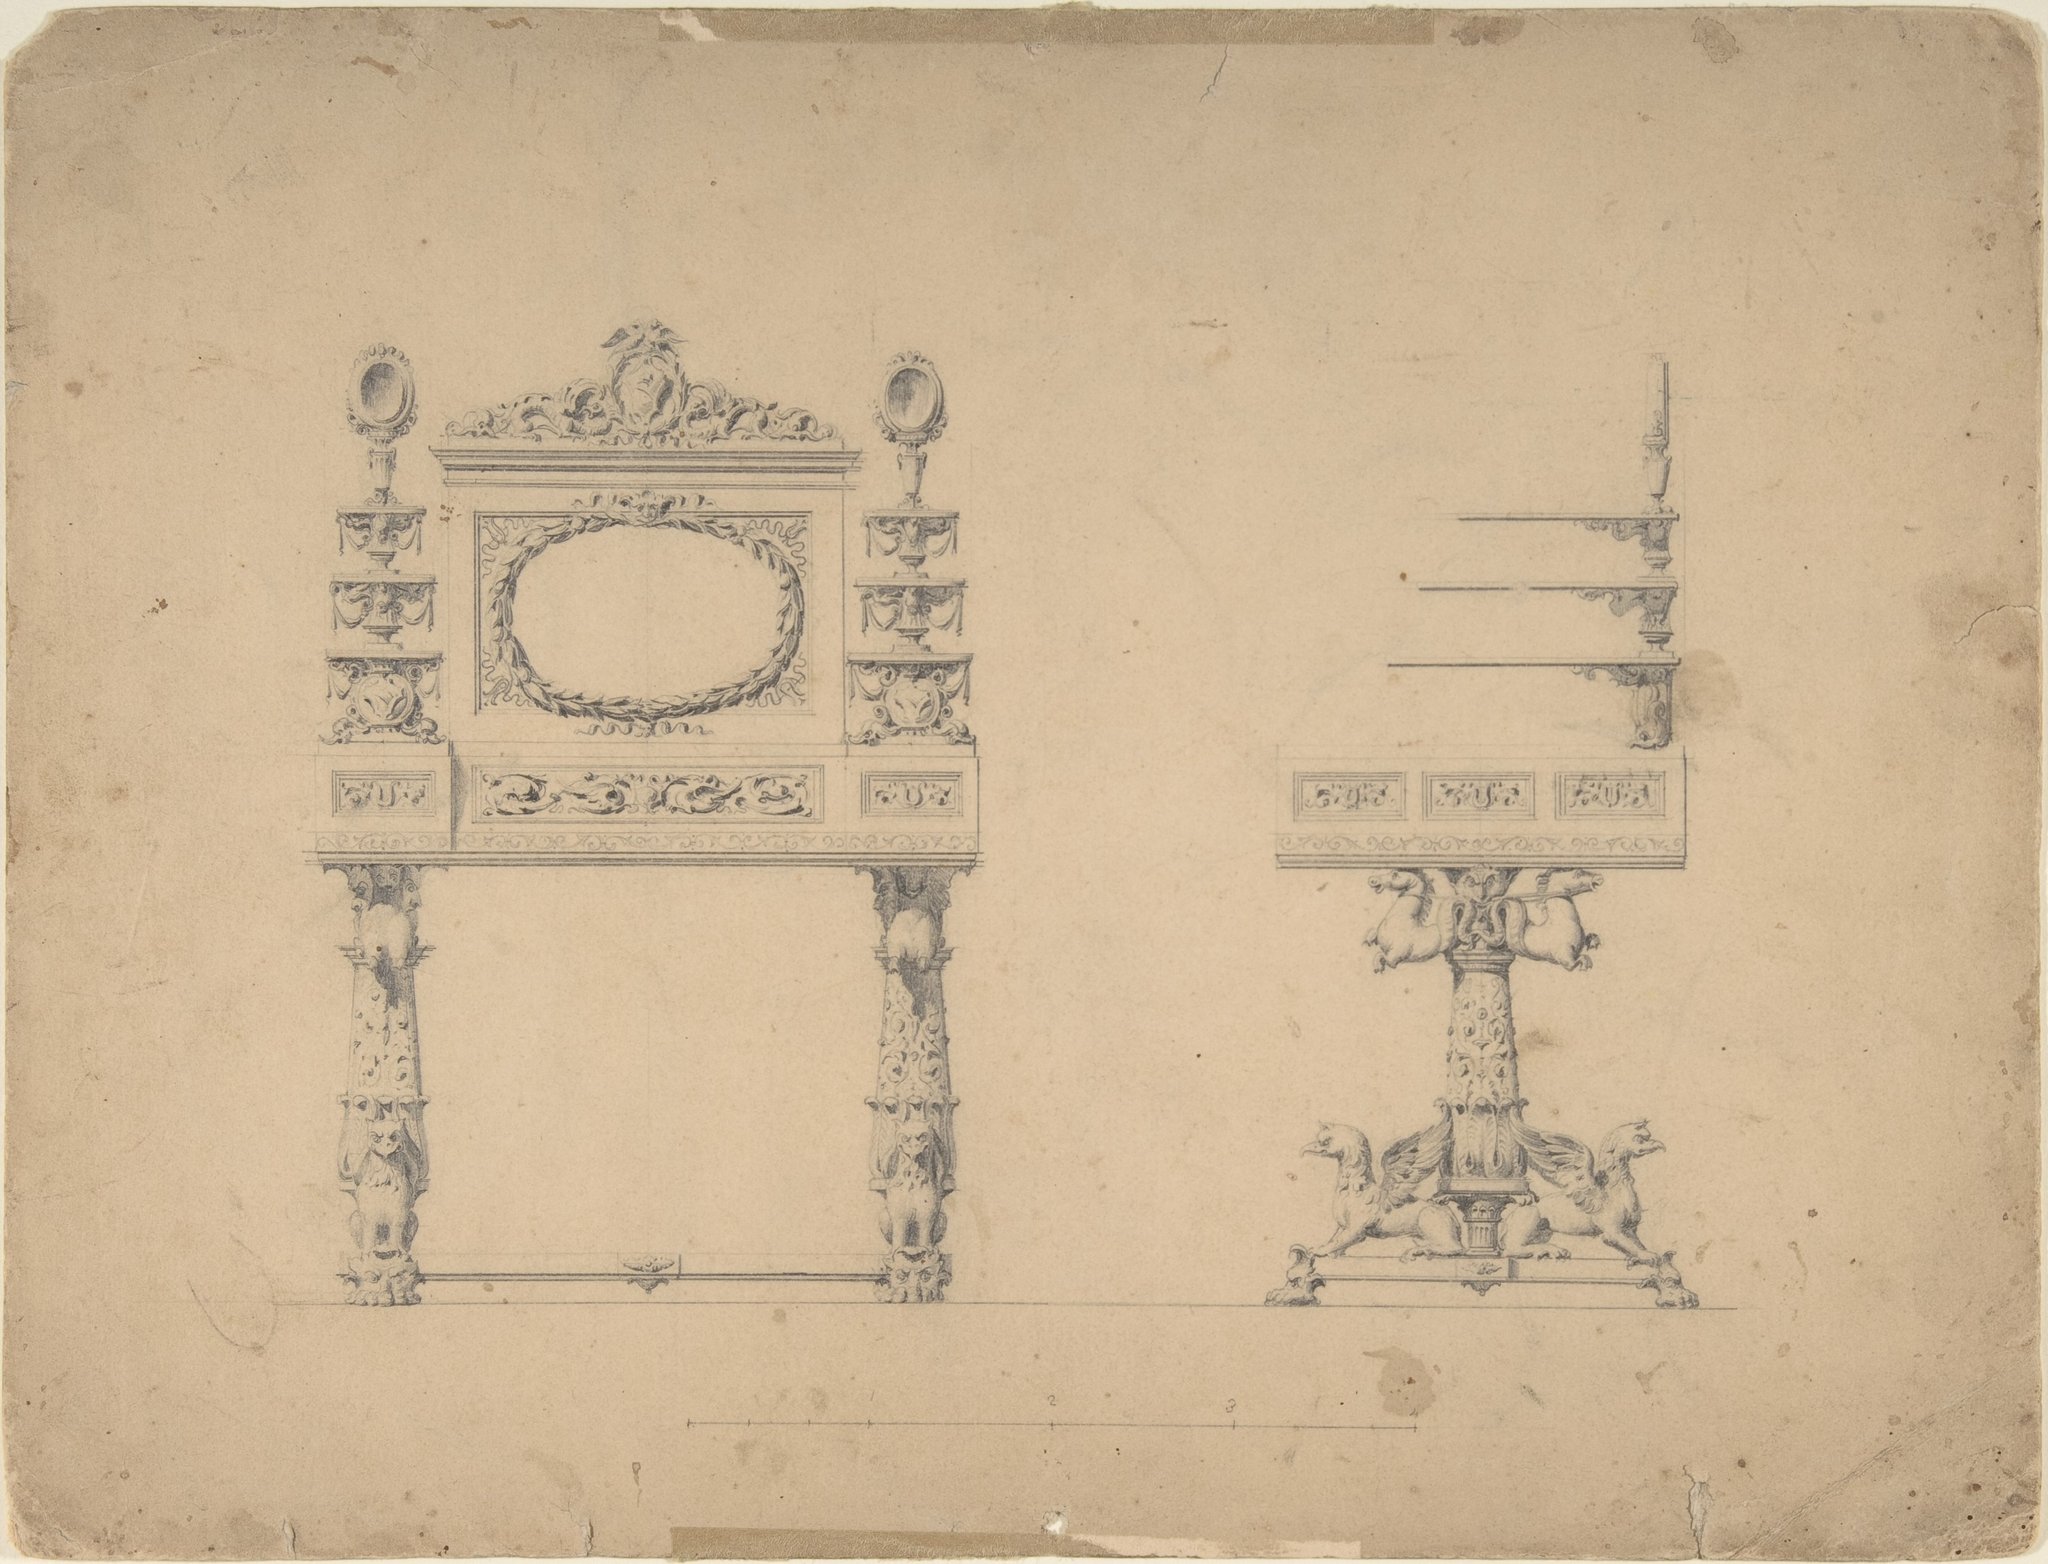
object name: drawing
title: Designs for Furniture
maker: anonymous, italian, 19th century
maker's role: artist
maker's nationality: italian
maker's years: 1800-1900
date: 1800-1900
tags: ornament,griffins,furniture